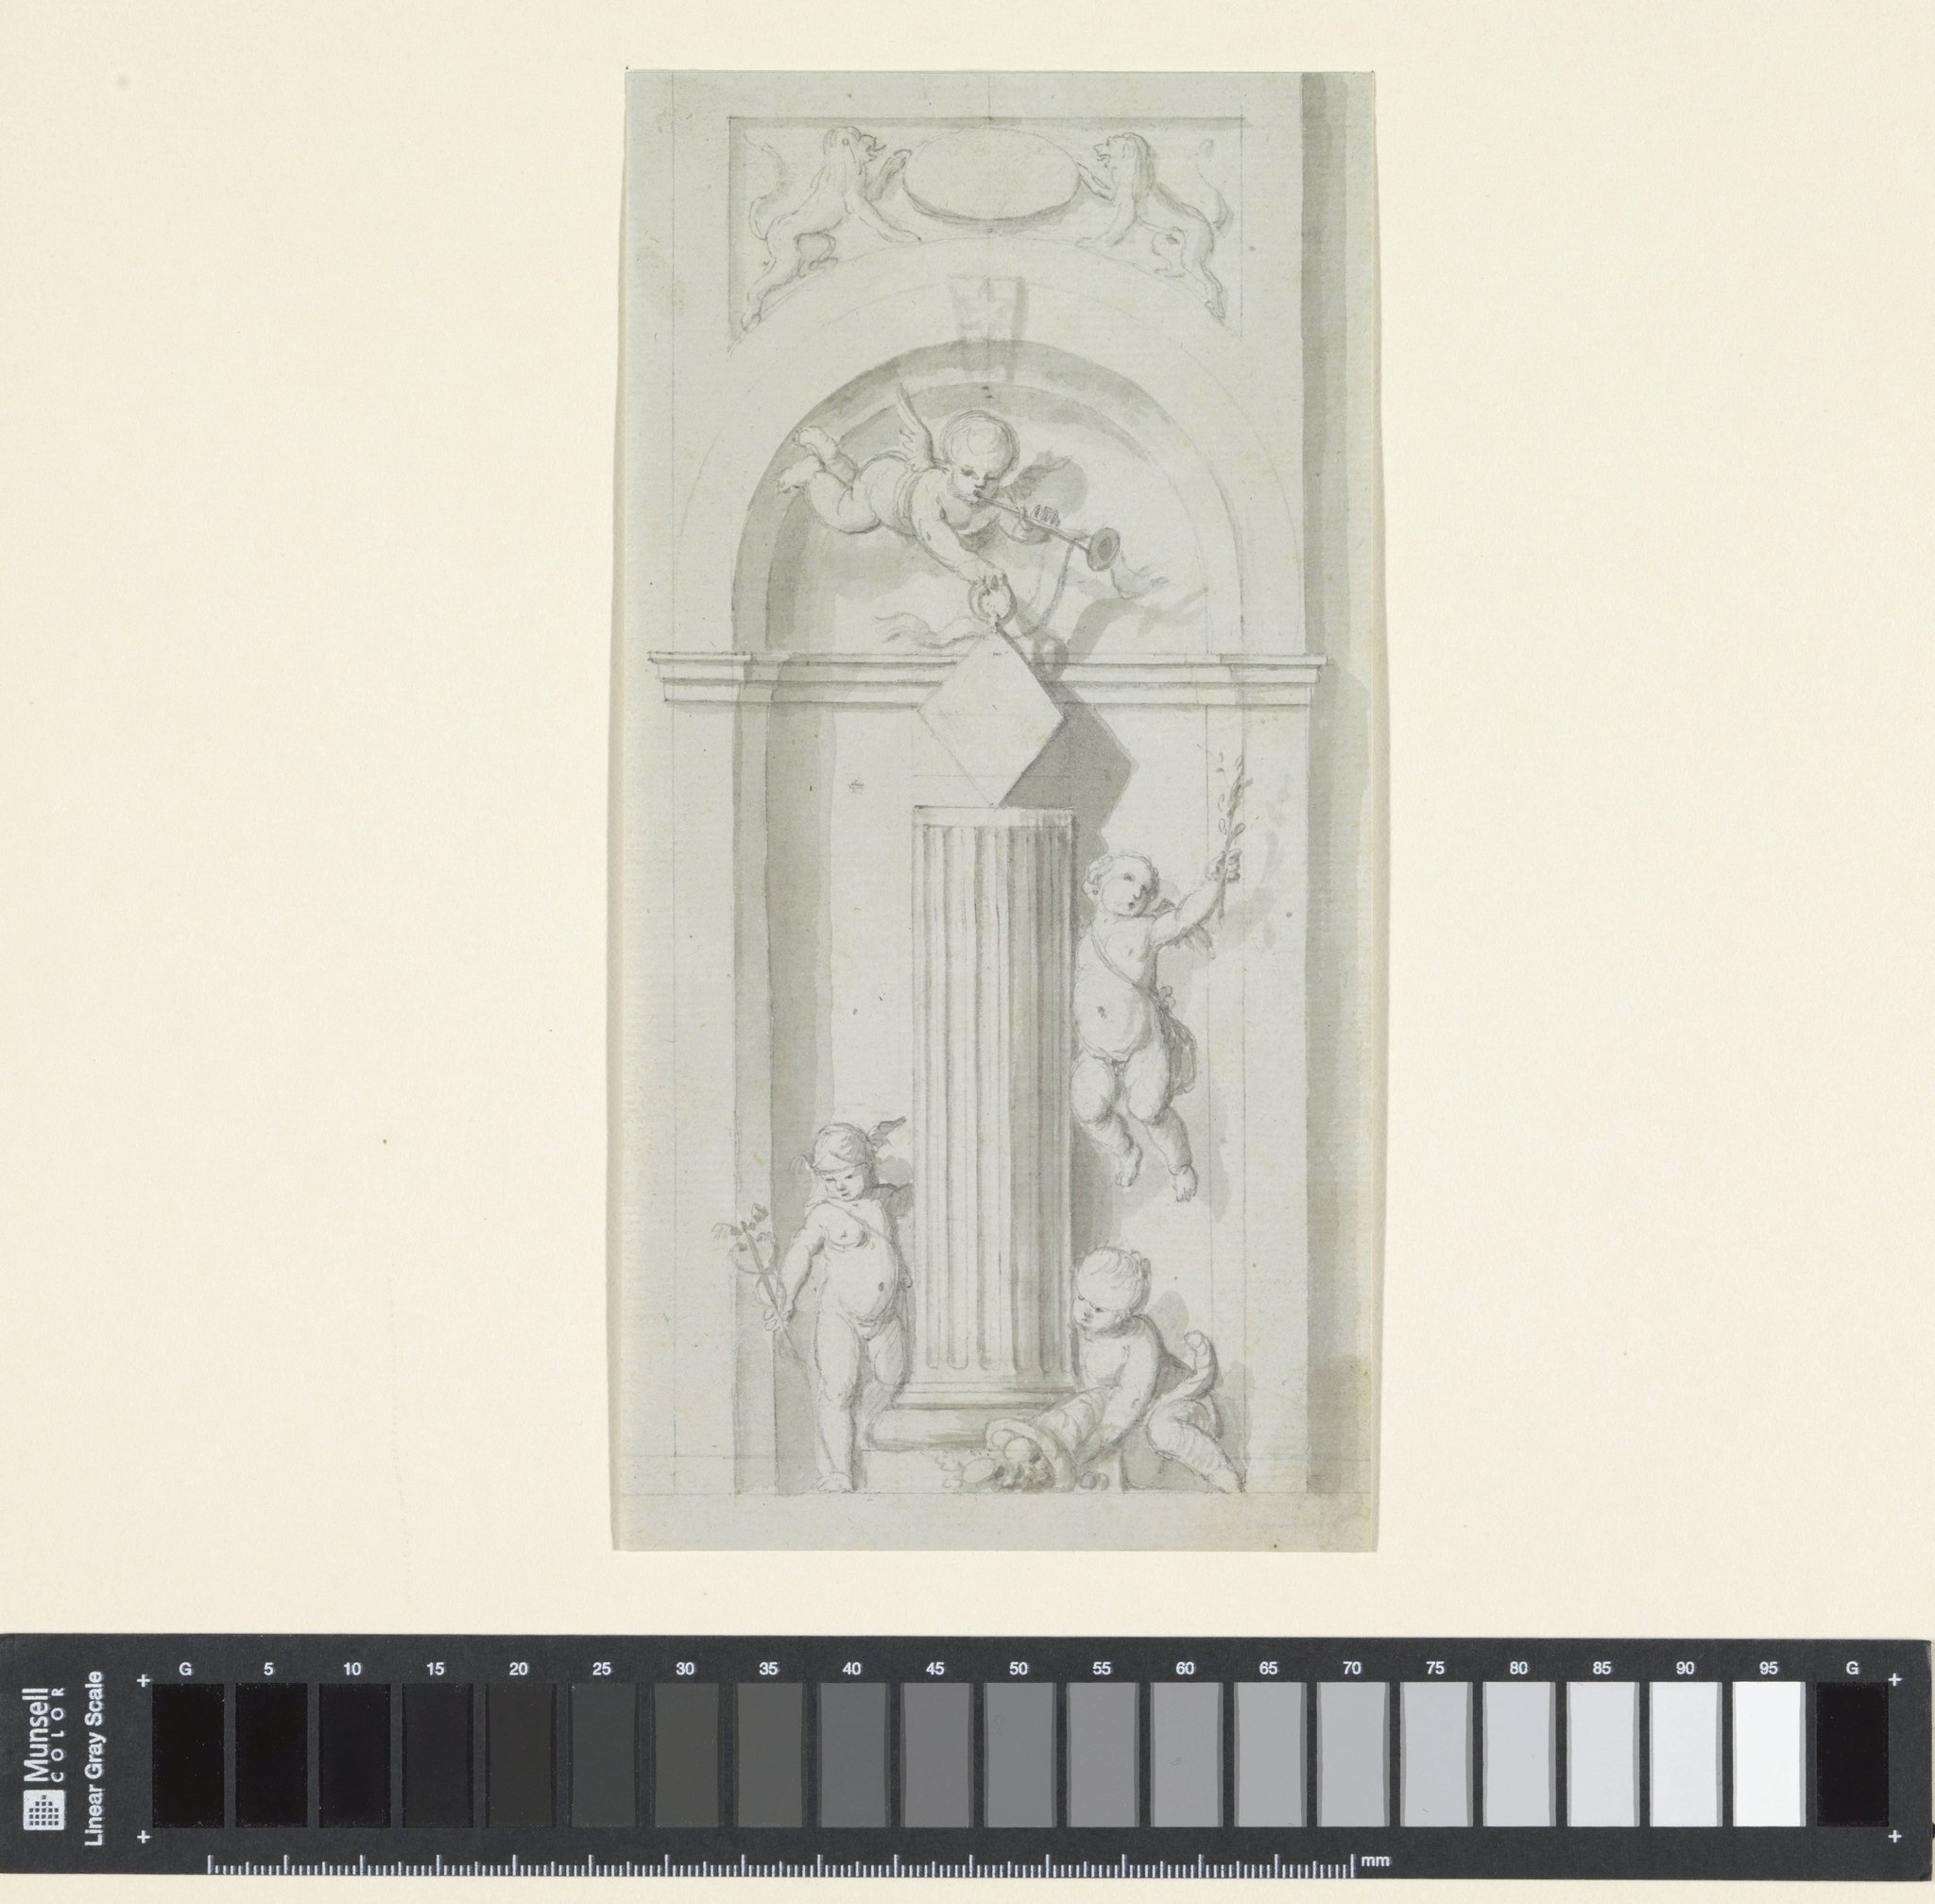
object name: ornamenttekening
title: Grafmonument met zuil en putti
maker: Anonymous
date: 1650-1800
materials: ink, paper, pencil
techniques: brush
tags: column, pillar ~ architecture, grave, tomb, cupids: 'amores', 'amoretti', 'putti'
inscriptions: collector's mark: Lugt 2228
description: Een grafmonument in een nis met een zuil en vier putti met attributen van Mercurius, een hoorn des overvloeds, een lauwertak, een bazuin en een ruitvorm. Aan de bovenzijde een paneel met een medaillon en twee leeuwen.